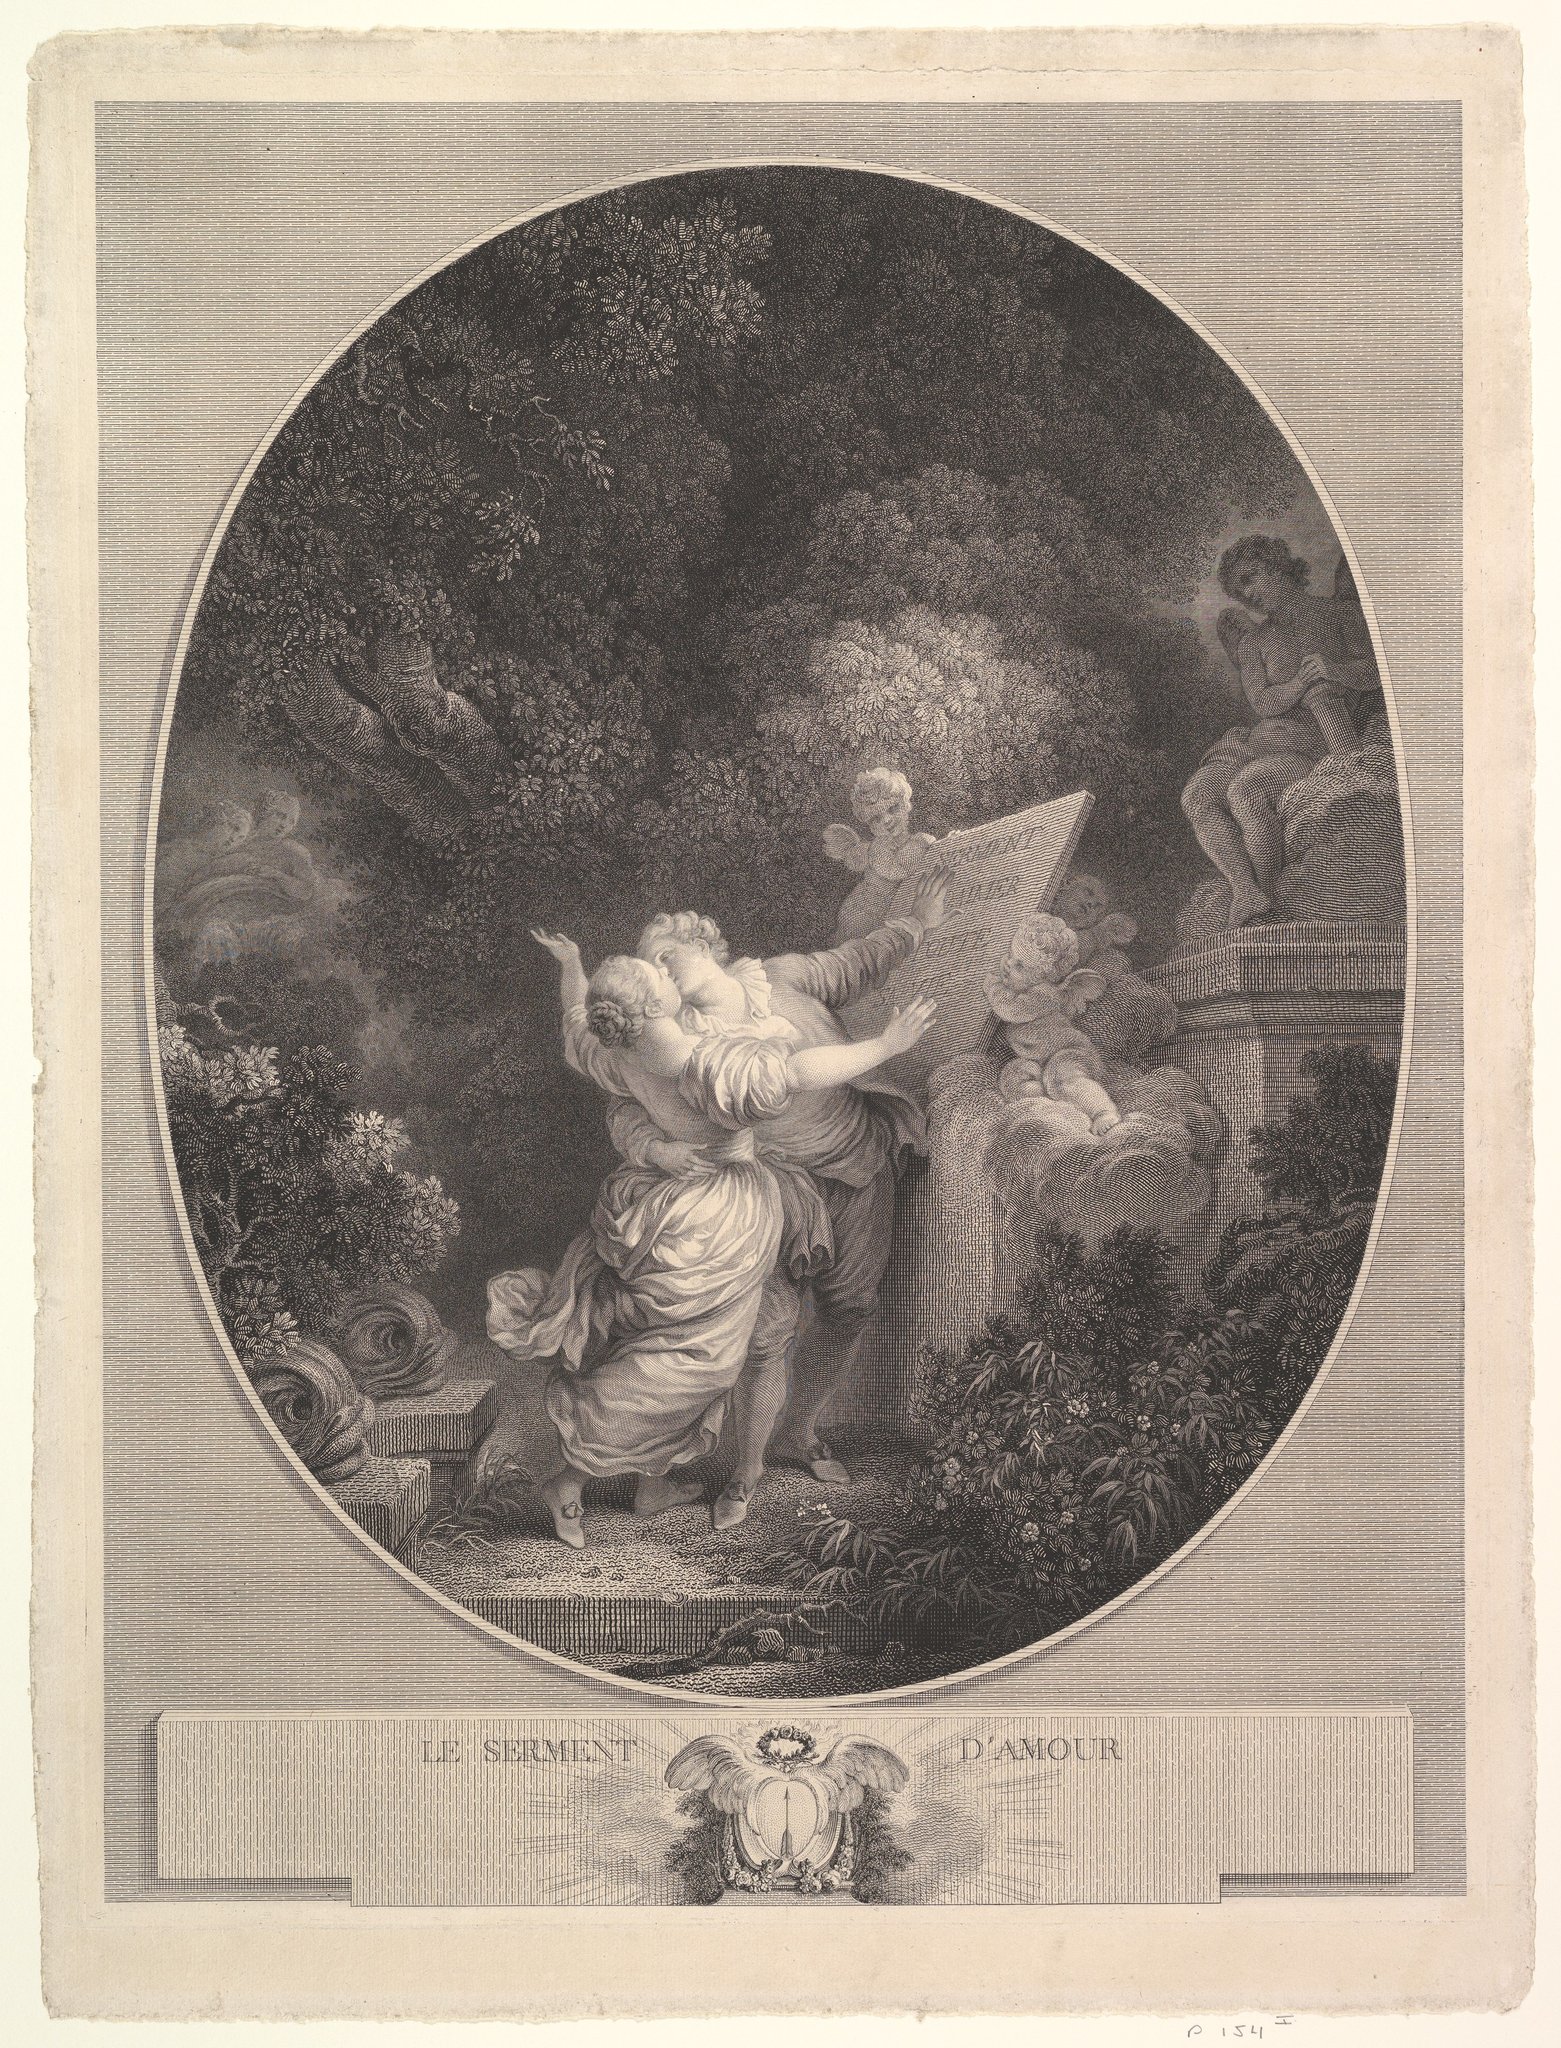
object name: print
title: The Pledge of Love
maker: jean mathieu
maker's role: artist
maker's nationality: french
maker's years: 1732-1806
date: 1786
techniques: engraving, etching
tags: love,couples,men,women,putti